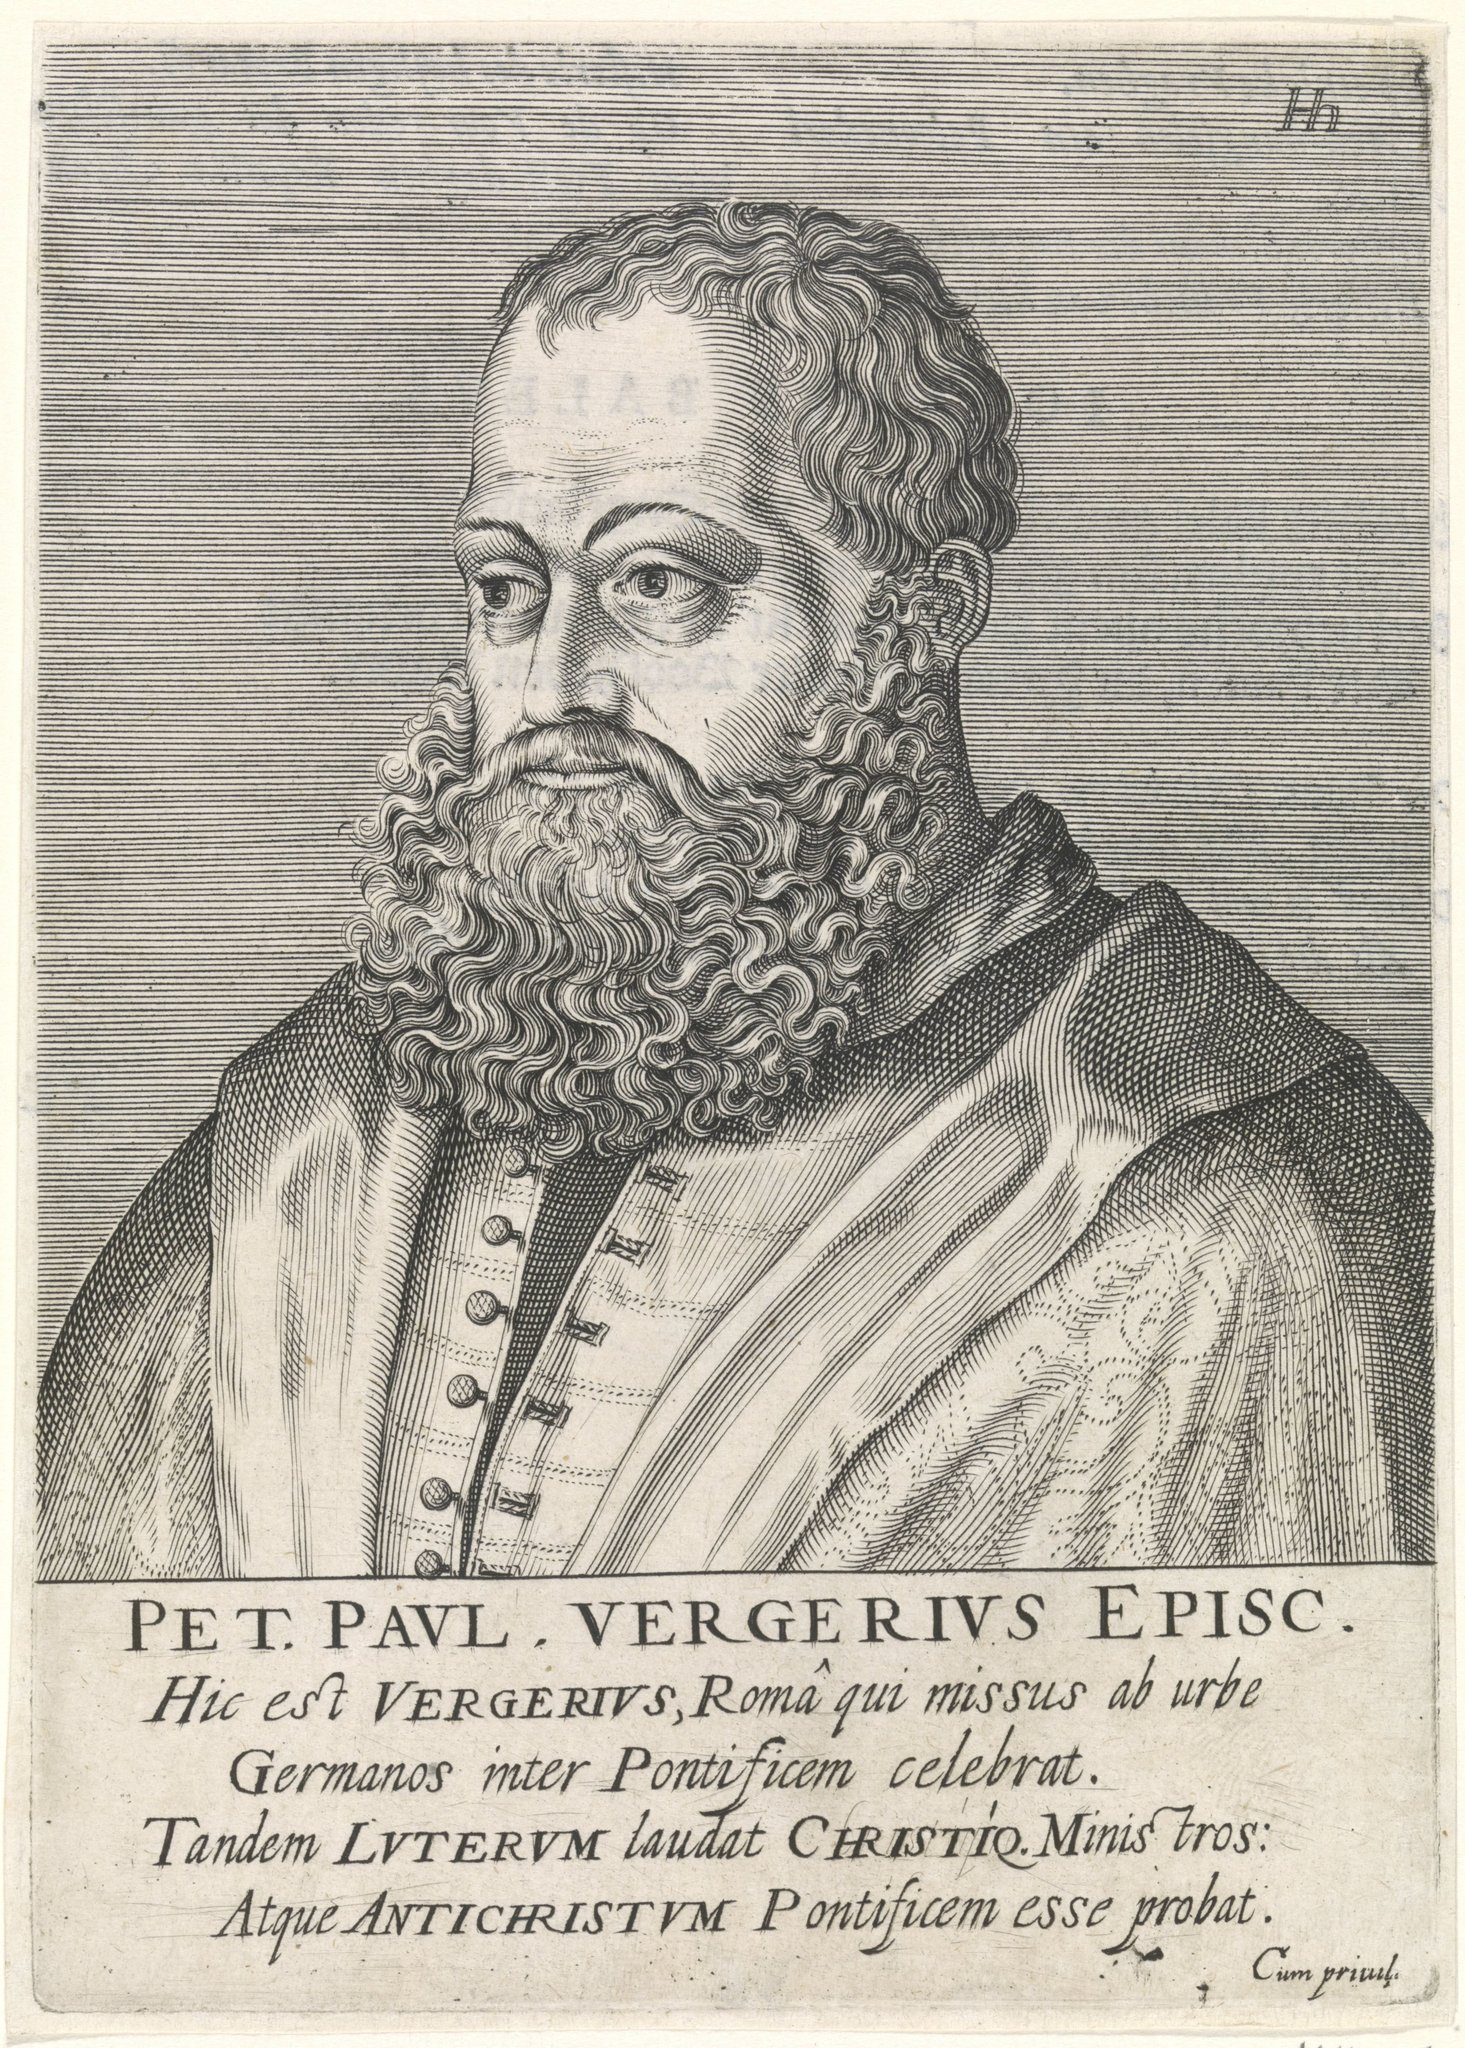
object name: book illustration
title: Beroemde hervormers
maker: hendrick hondius (i)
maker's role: draughtsman, print maker, publisher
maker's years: 1573-1650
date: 1599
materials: paper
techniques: engraving, letterpress printing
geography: the hague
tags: pietro paolo vergerio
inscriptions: collector's mark: Lugt 2228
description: Prent ook gebruikt als boekillustratie in: Jacob Verheiden, Præstantium aliquot theologorum, qui rom. antichristum præcipuè oppugnarunt, effigies. Den Haag: Hendrick Hondius I en Den Haag: B.C. Nieulandt, 1602-1603. Tevens: Arnhem, J.Janssen, 1604.